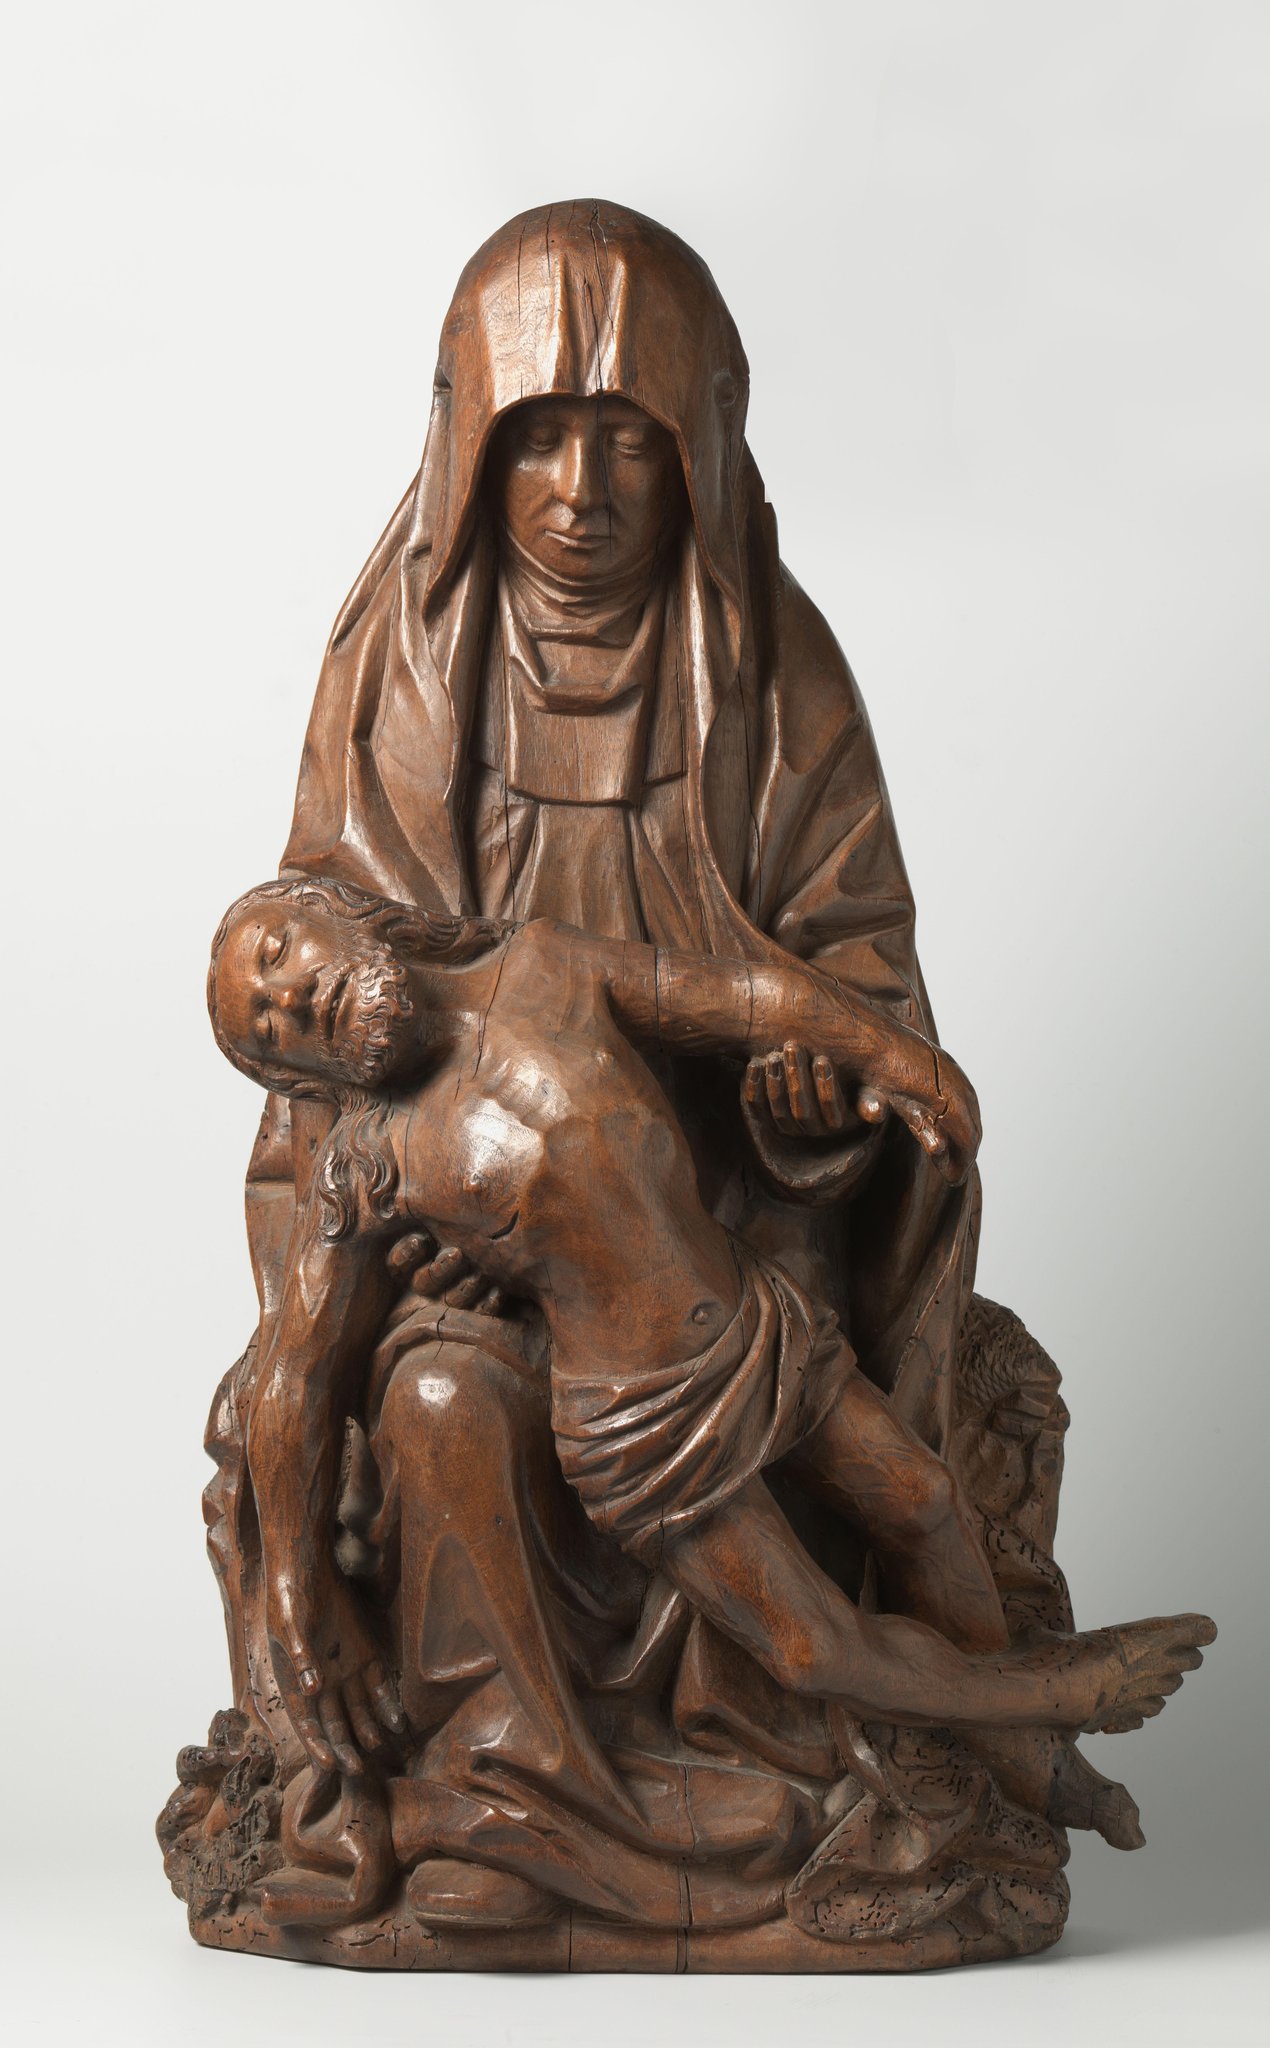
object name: sculpture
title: Pietà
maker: Anonymous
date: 1500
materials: wood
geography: north brabant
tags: 'pietà ', 'vesperbild', 'marienklage' (no others present): christ, either with or without crown of thorns, mourned by mary, mary sitting or enthroned, the christ-child in front of her, lying in her lap (or in front of her bosom), sometimes in pietà-posture